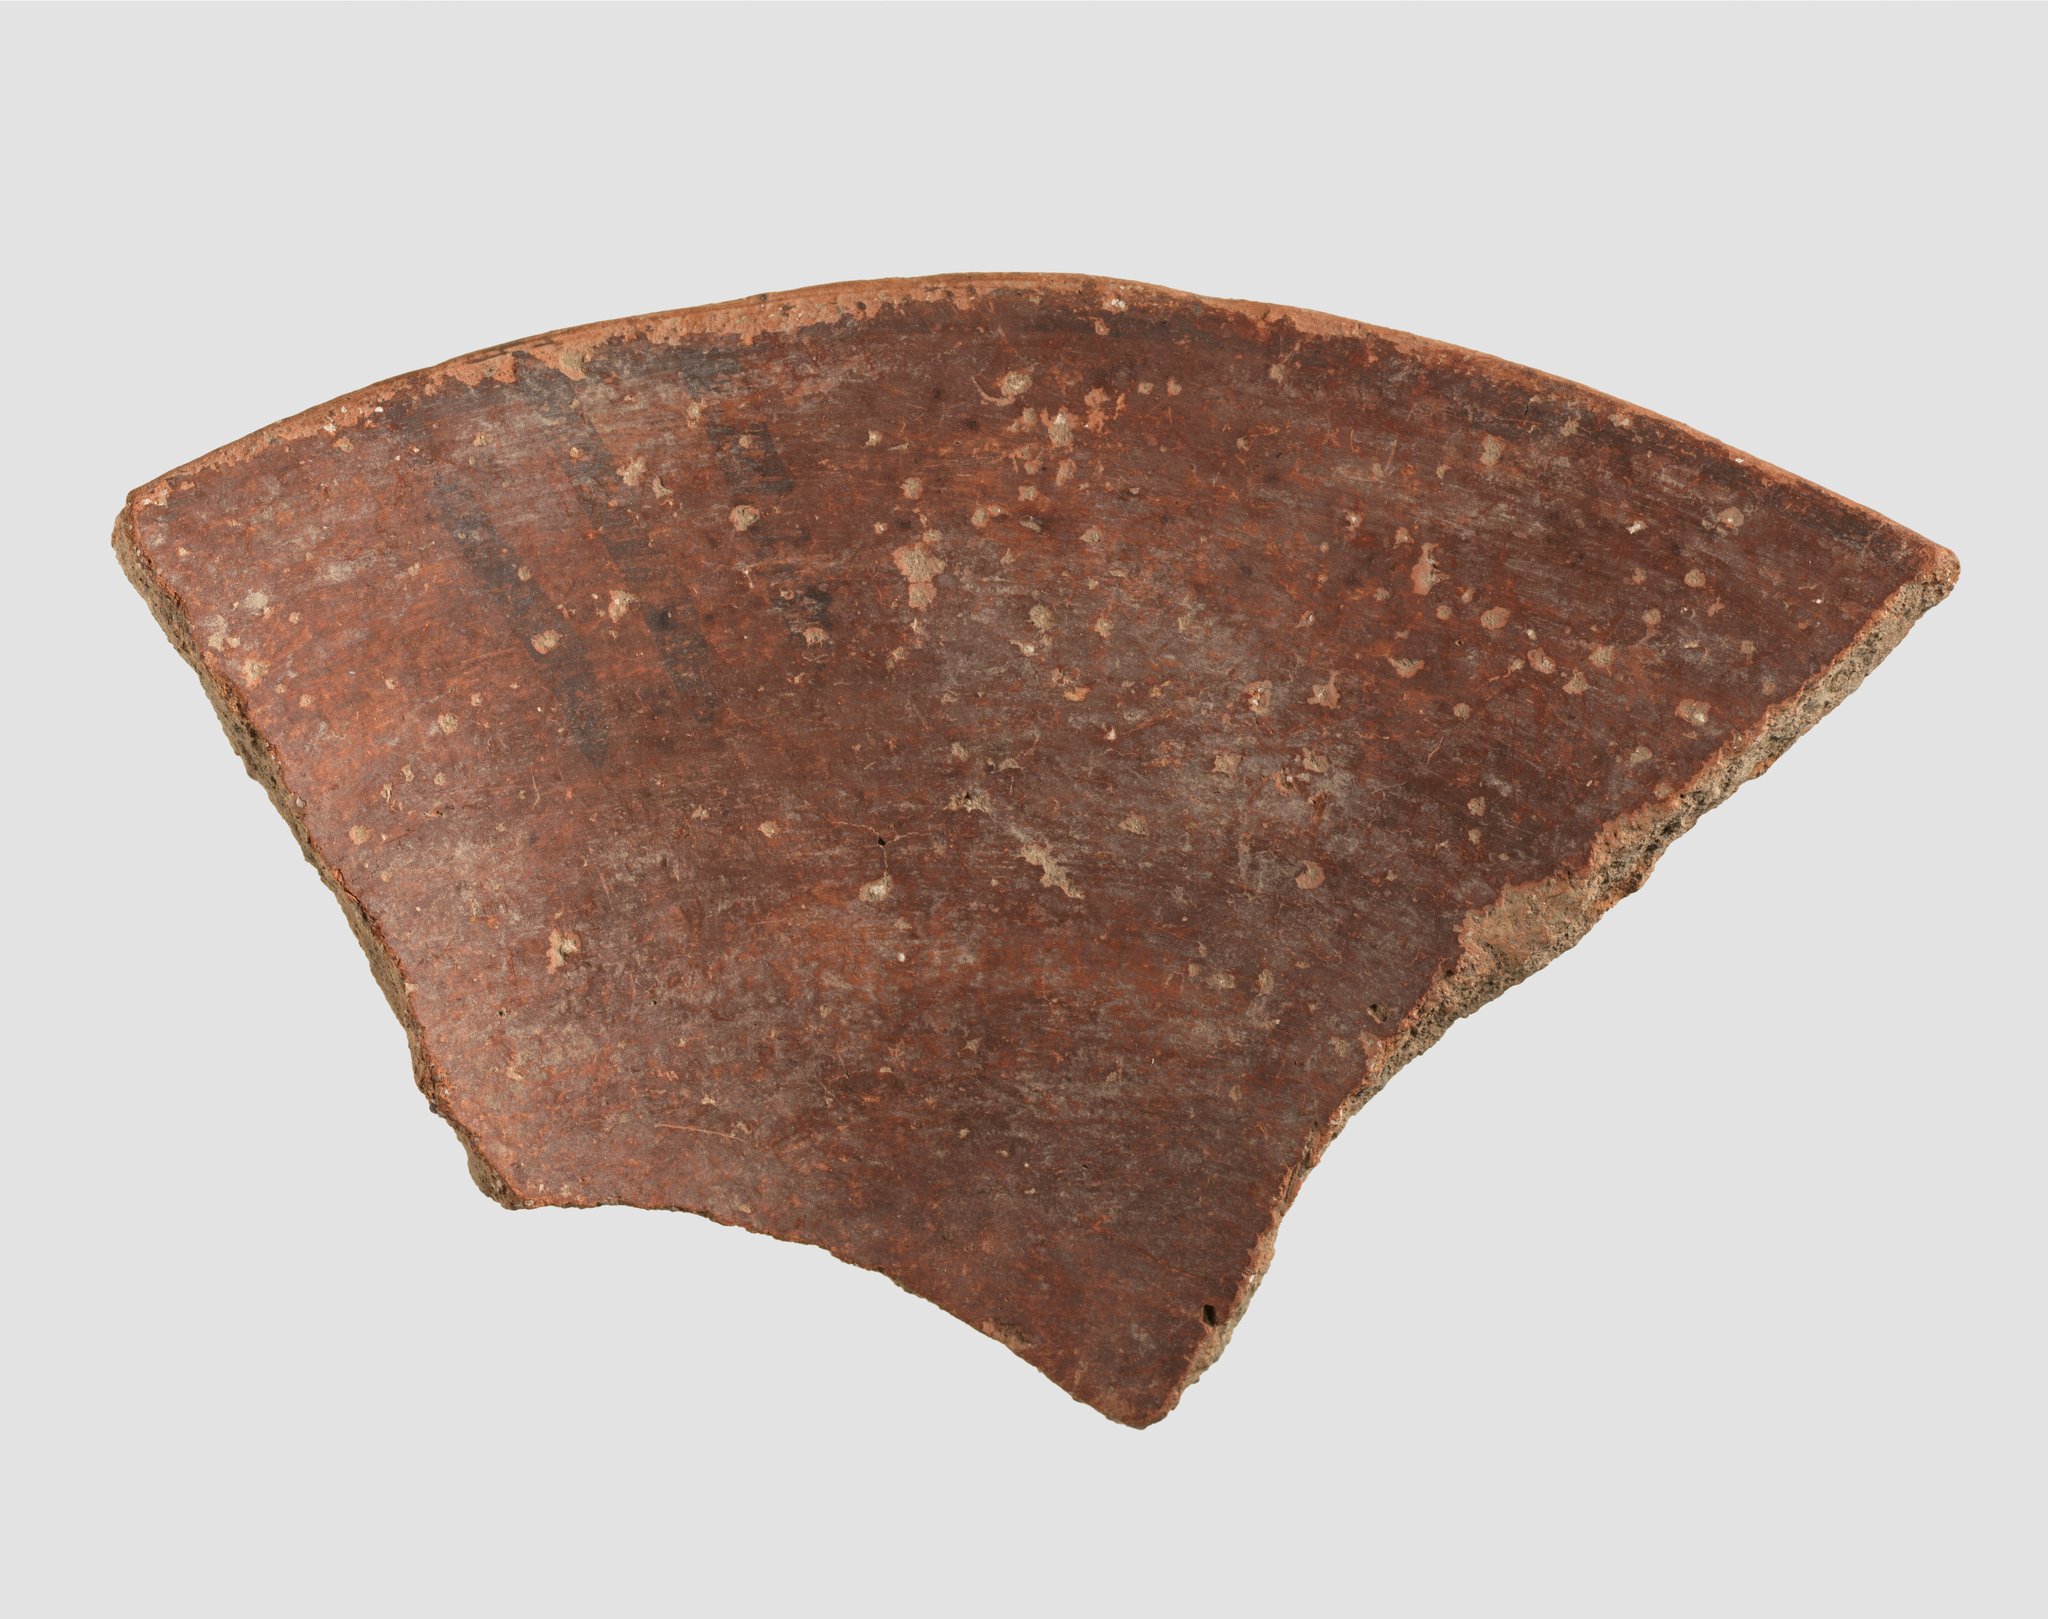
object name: sherd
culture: iranian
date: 3500-3100 BCE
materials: ceramic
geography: iran